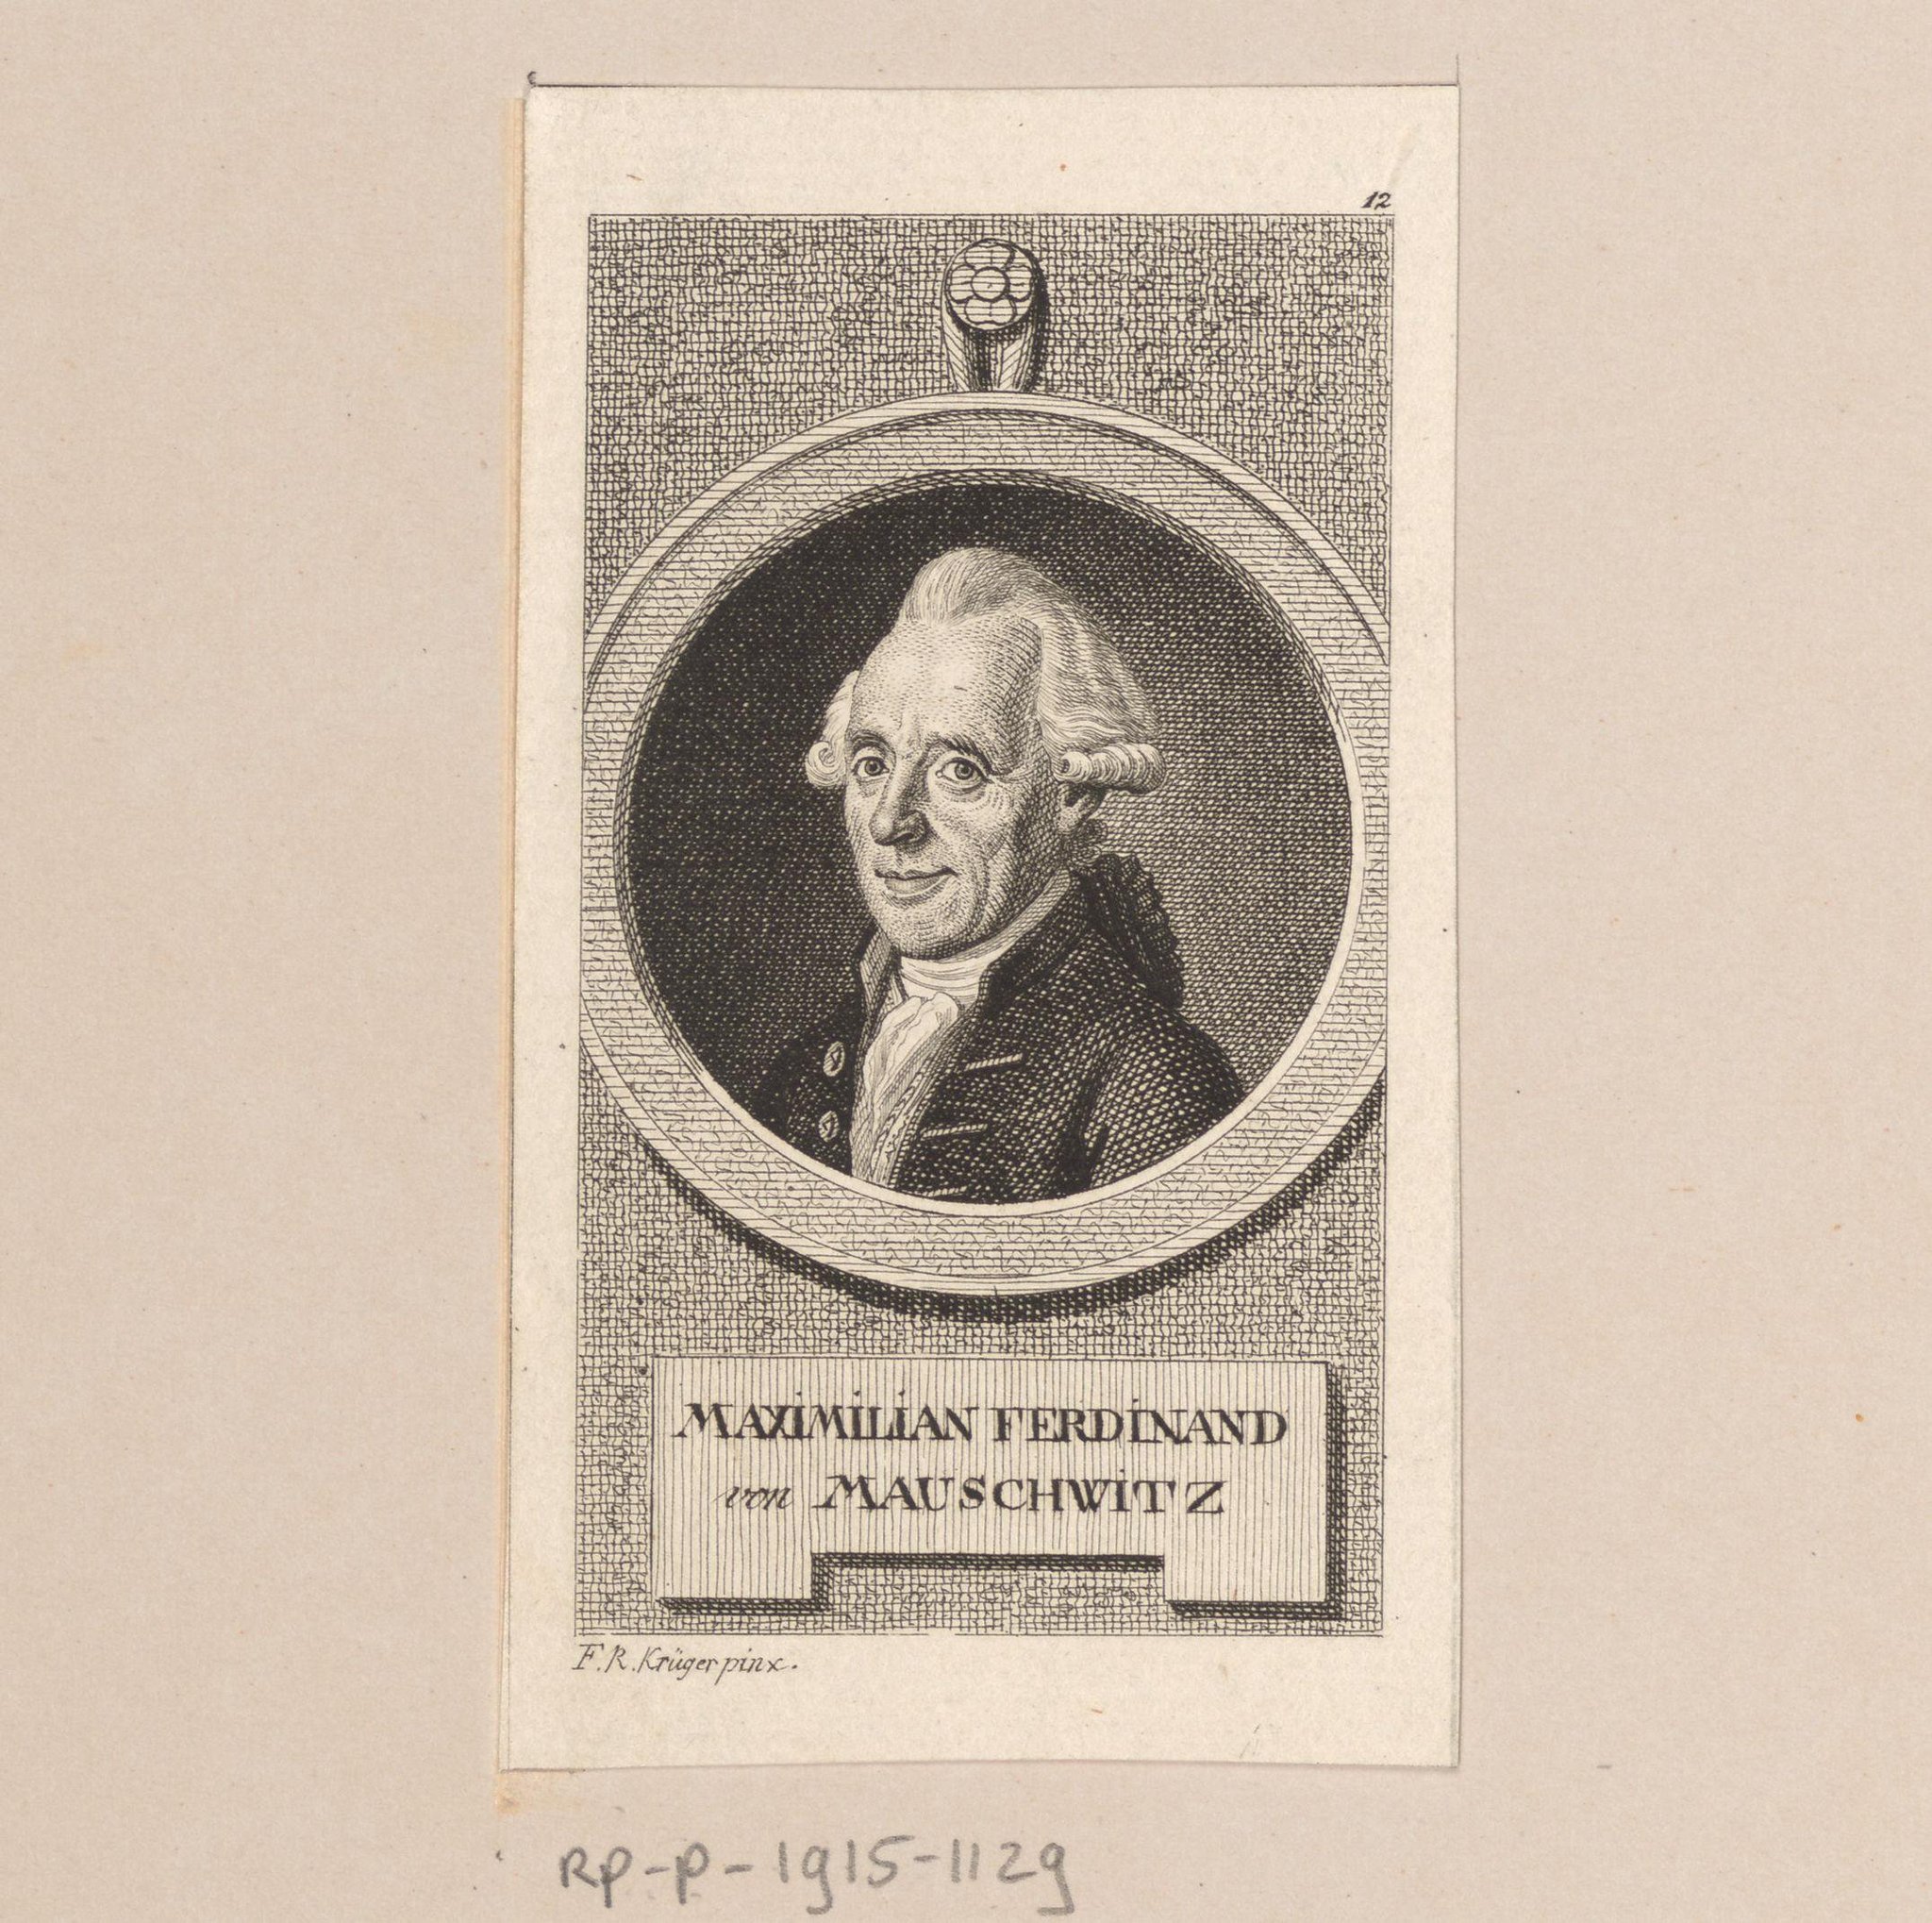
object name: print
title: Portret van Karl Maximilian Ferdinand von Mauschwitz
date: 1770-1820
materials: paper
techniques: engraving, etching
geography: germany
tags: politician, ornament ~ medallion, historical persons